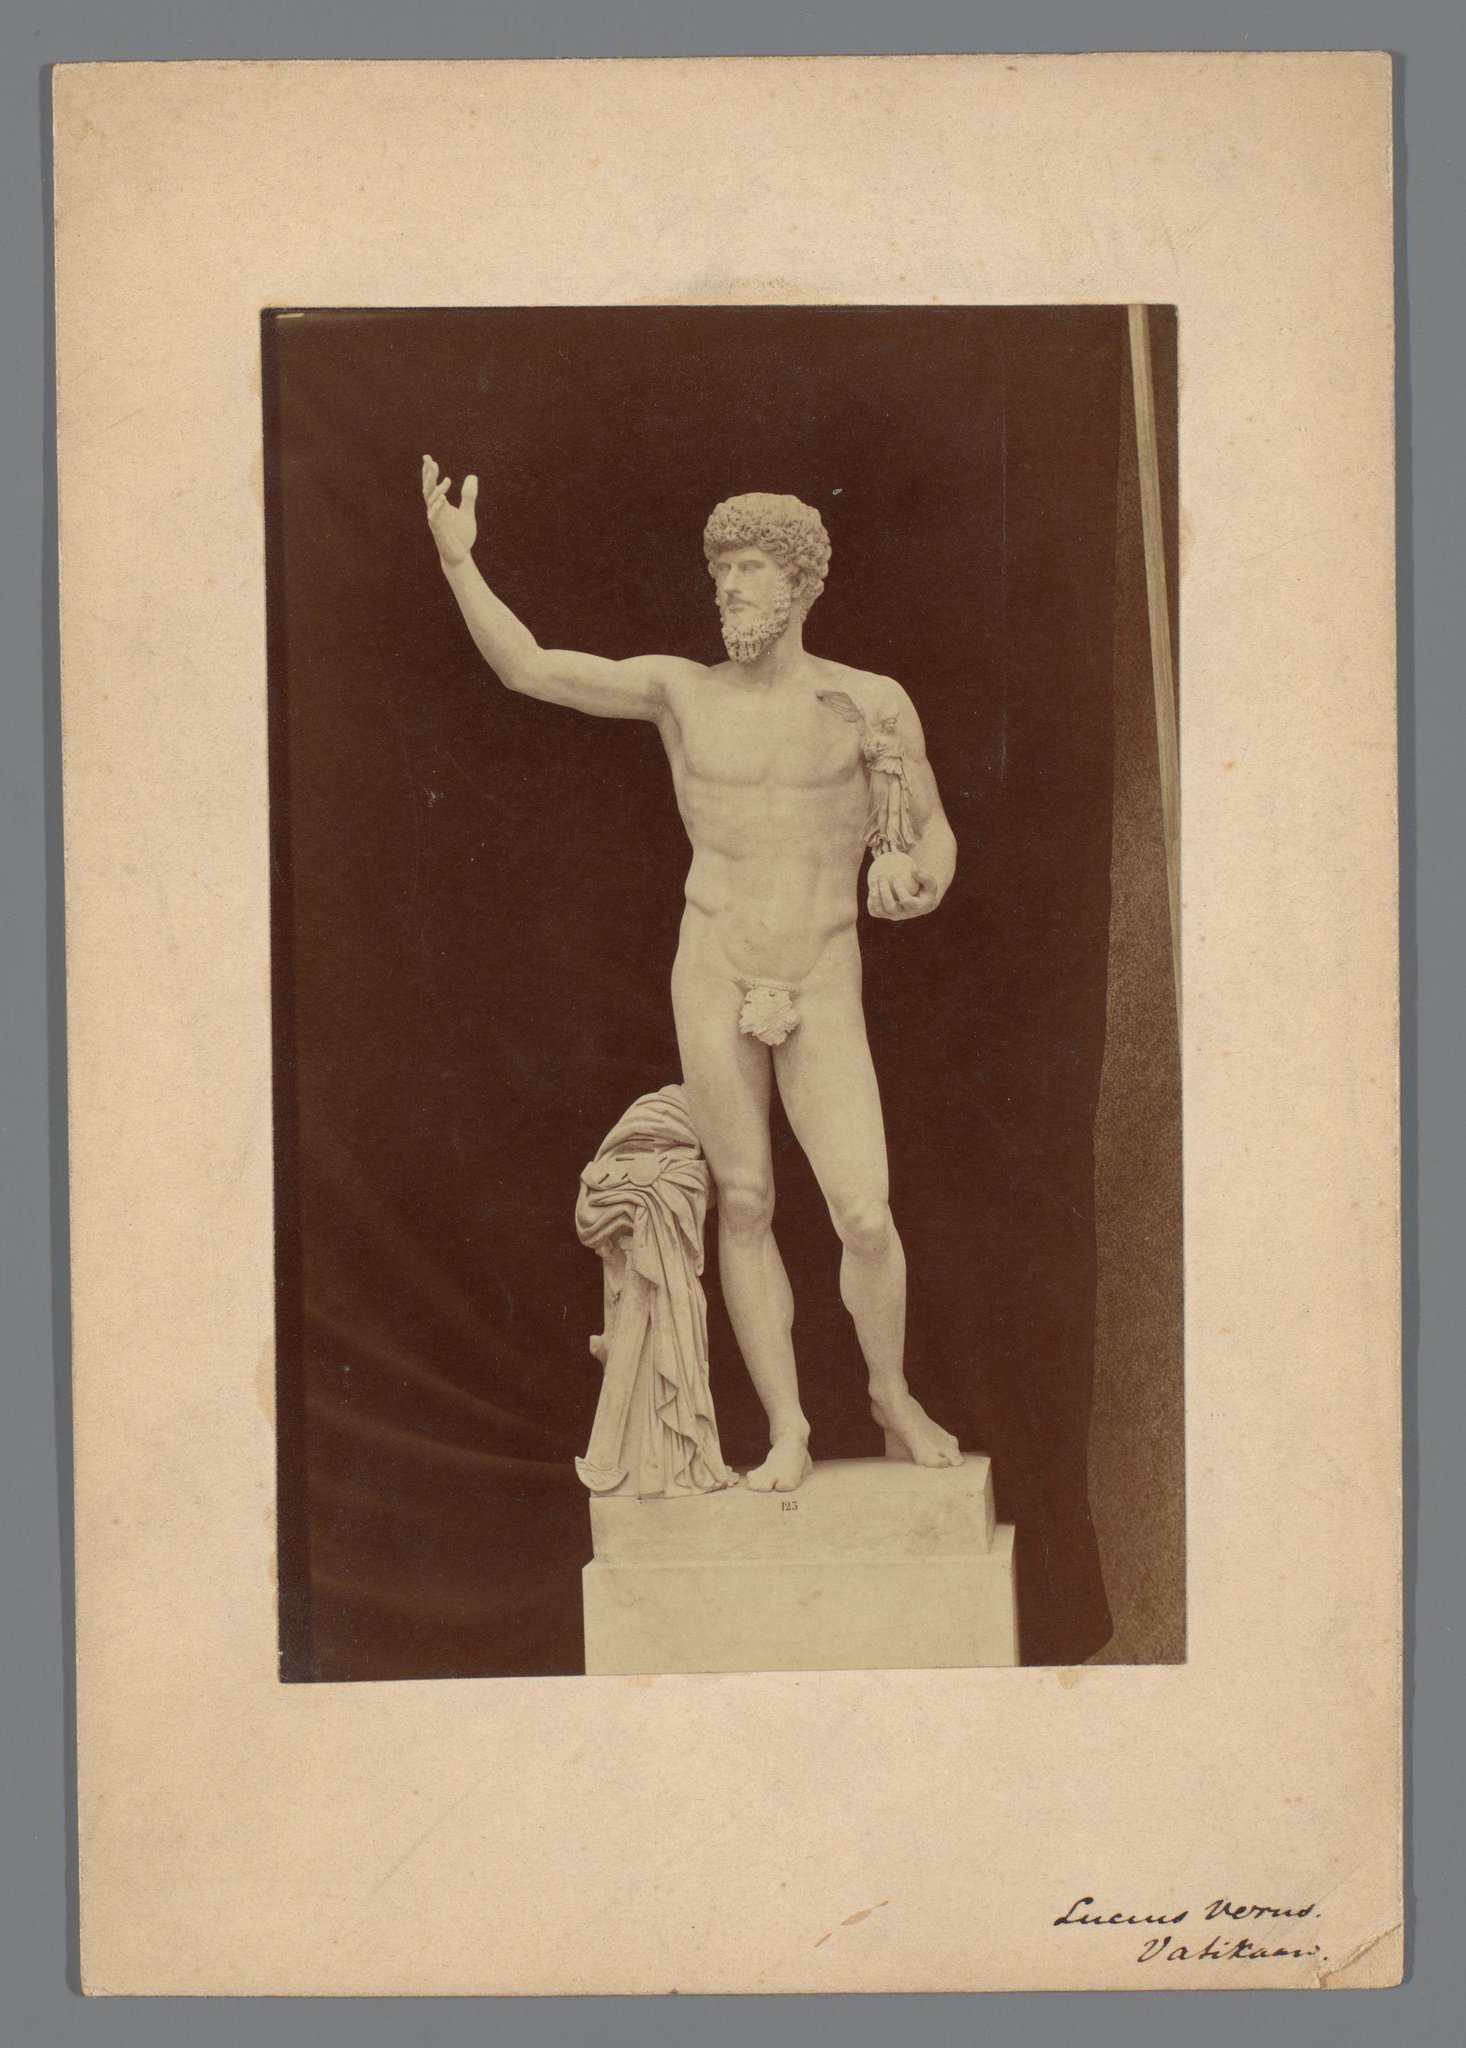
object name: photograph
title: Sculptuur van Lucius Verus in het Vaticaan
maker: Anonymous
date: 1850-1900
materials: cardboard, photographic support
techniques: albumen print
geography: vatican city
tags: emperor, monument, statue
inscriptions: collector's mark: ‘RIJKS NORMAALSCHOOL voor TEEKENONDERWIJZERS AMSTERDAM’, annotation: ‘Lucius Verus/ Vatikaan.’, annotation: ‘G.’